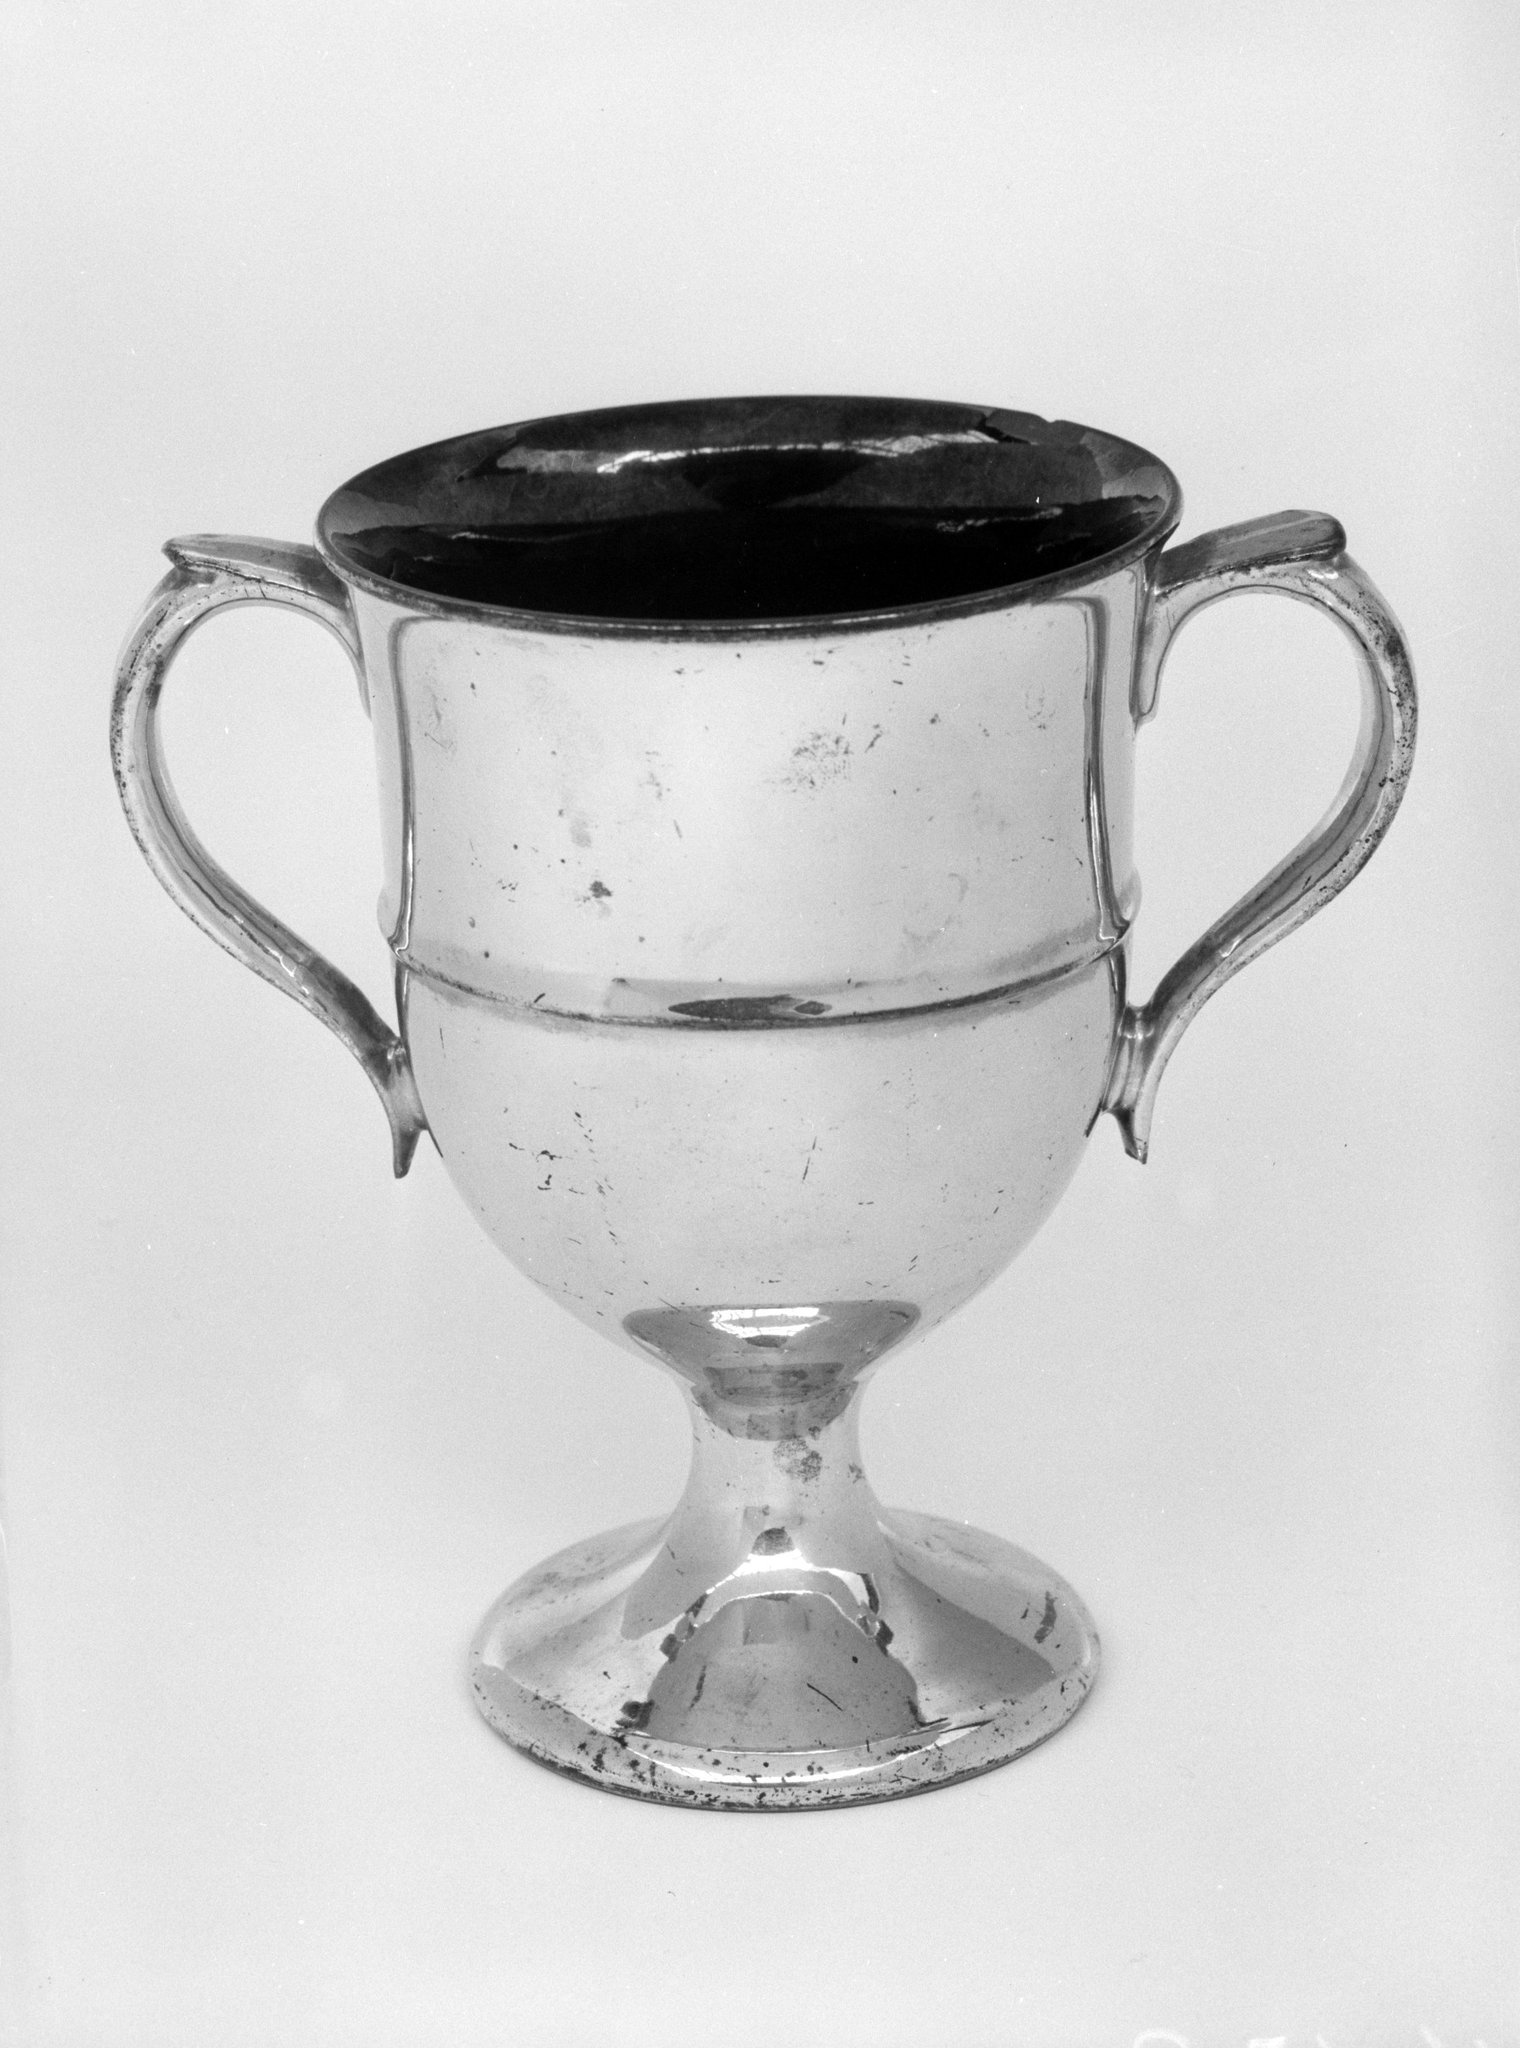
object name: cup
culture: british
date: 1800-1830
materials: earthenware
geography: england